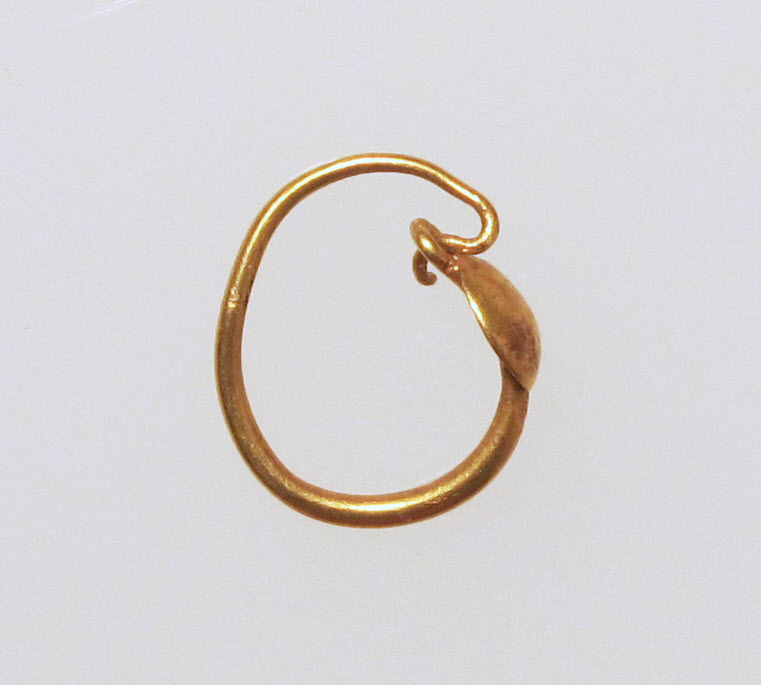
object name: earring with plain loop and disc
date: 7000 BCE-330 CE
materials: gold